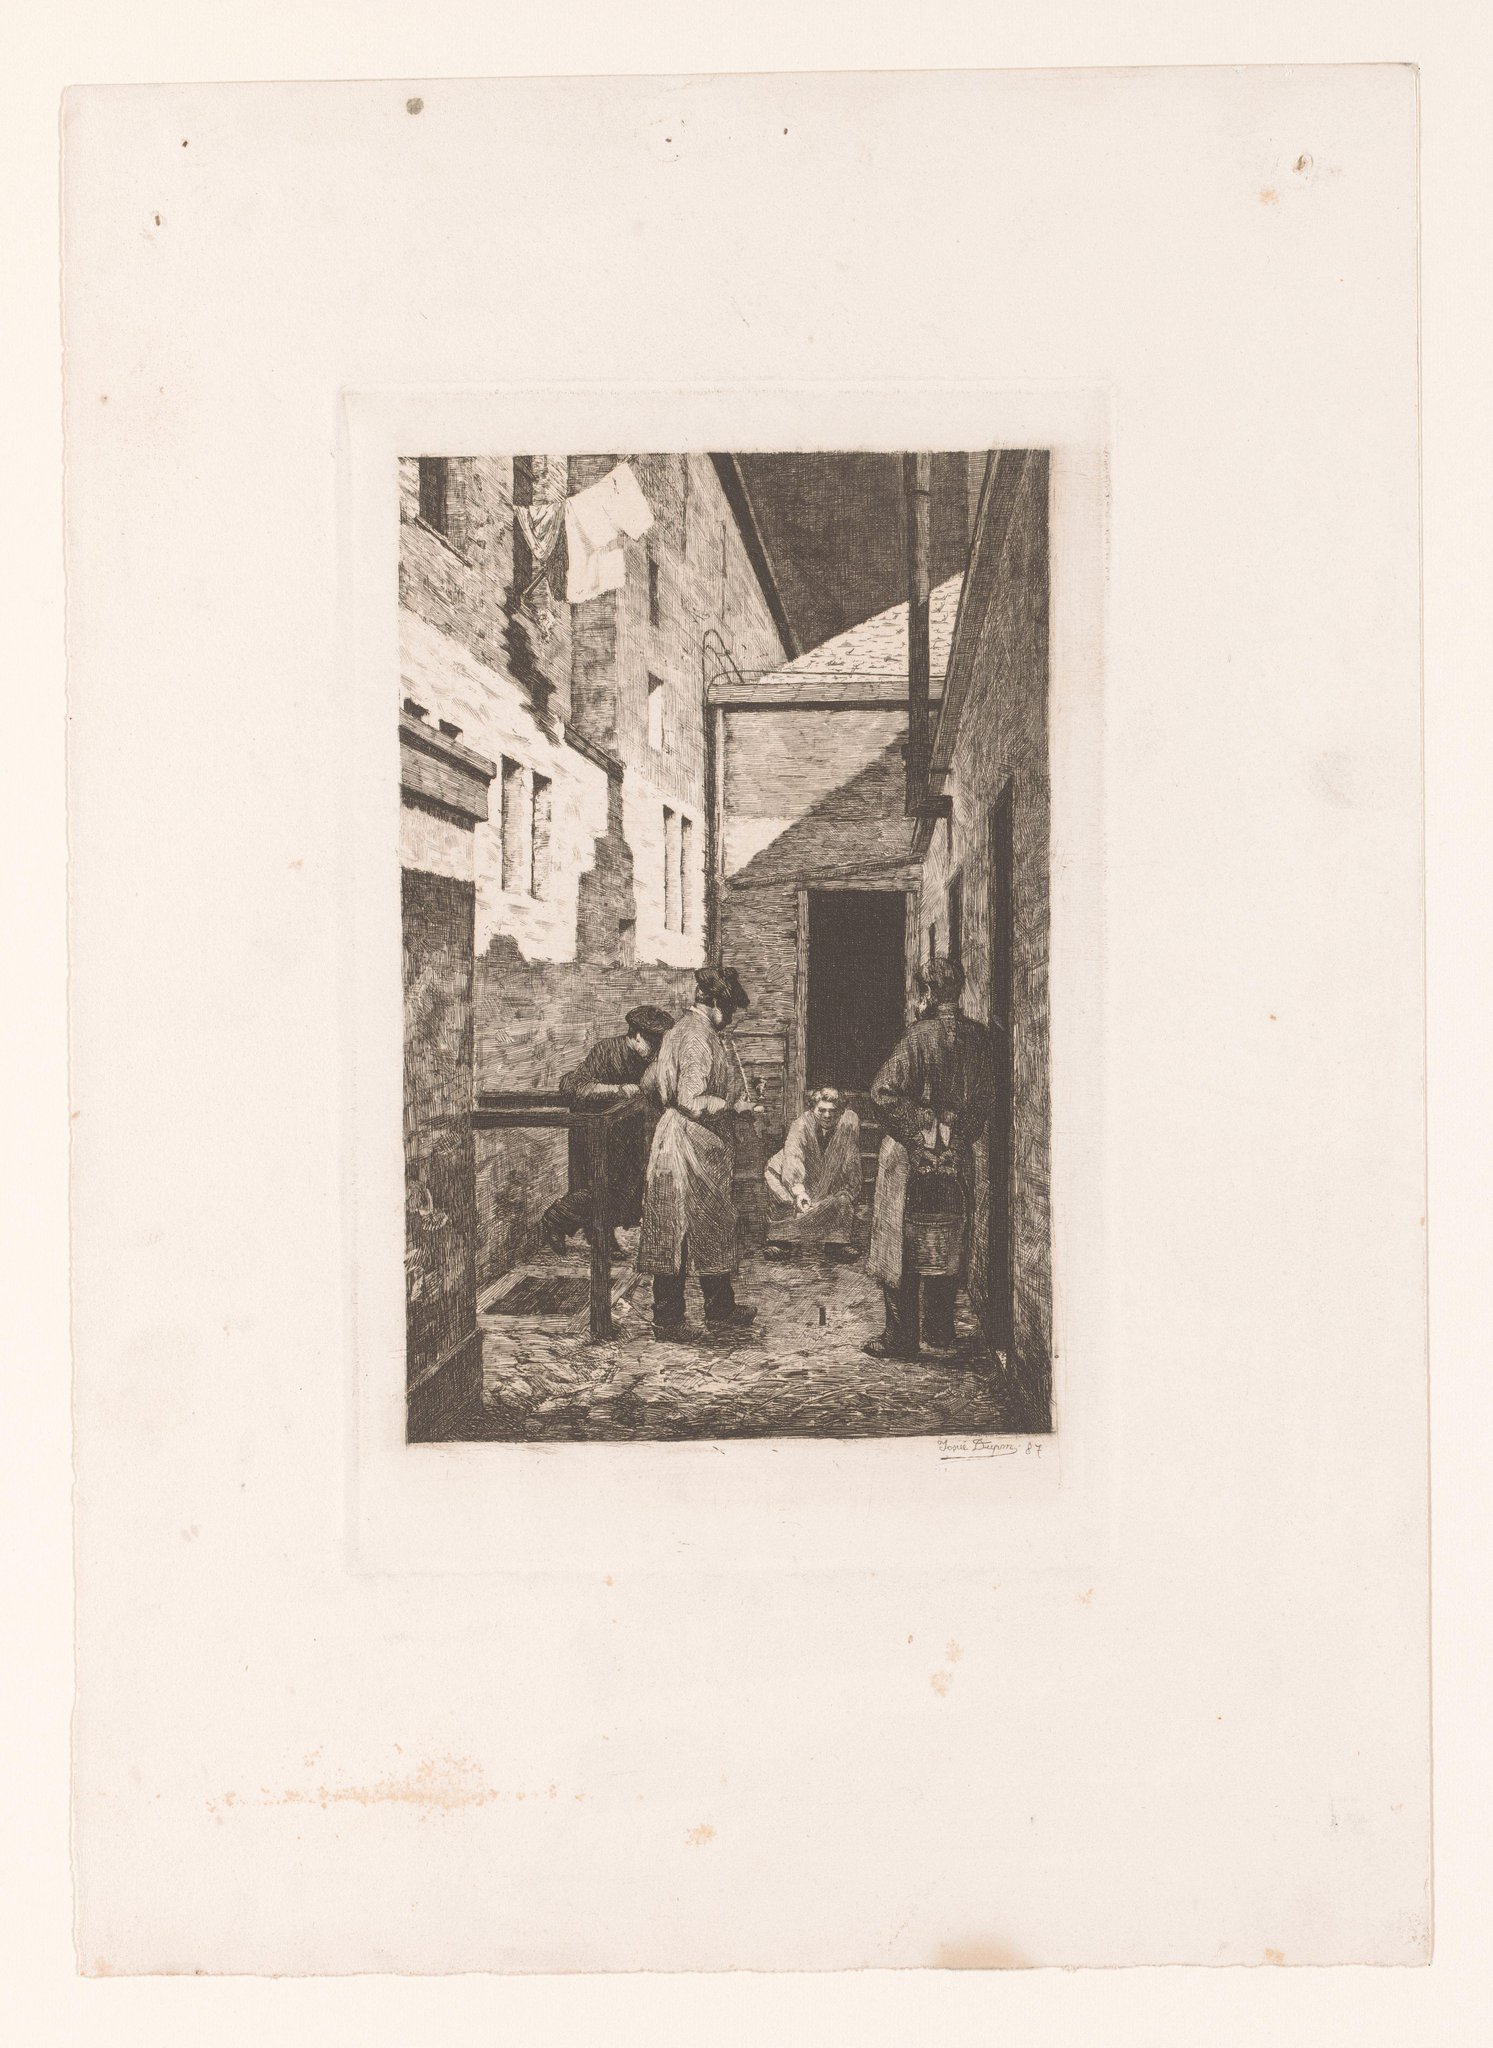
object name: print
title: Vier figuren spelen een spel met kurken in een steeg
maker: josué dupon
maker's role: print maker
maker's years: 1864-1935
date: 1887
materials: paper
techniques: etching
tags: children's games and plays, lane, alley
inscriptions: collector's mark: Lugt 2228